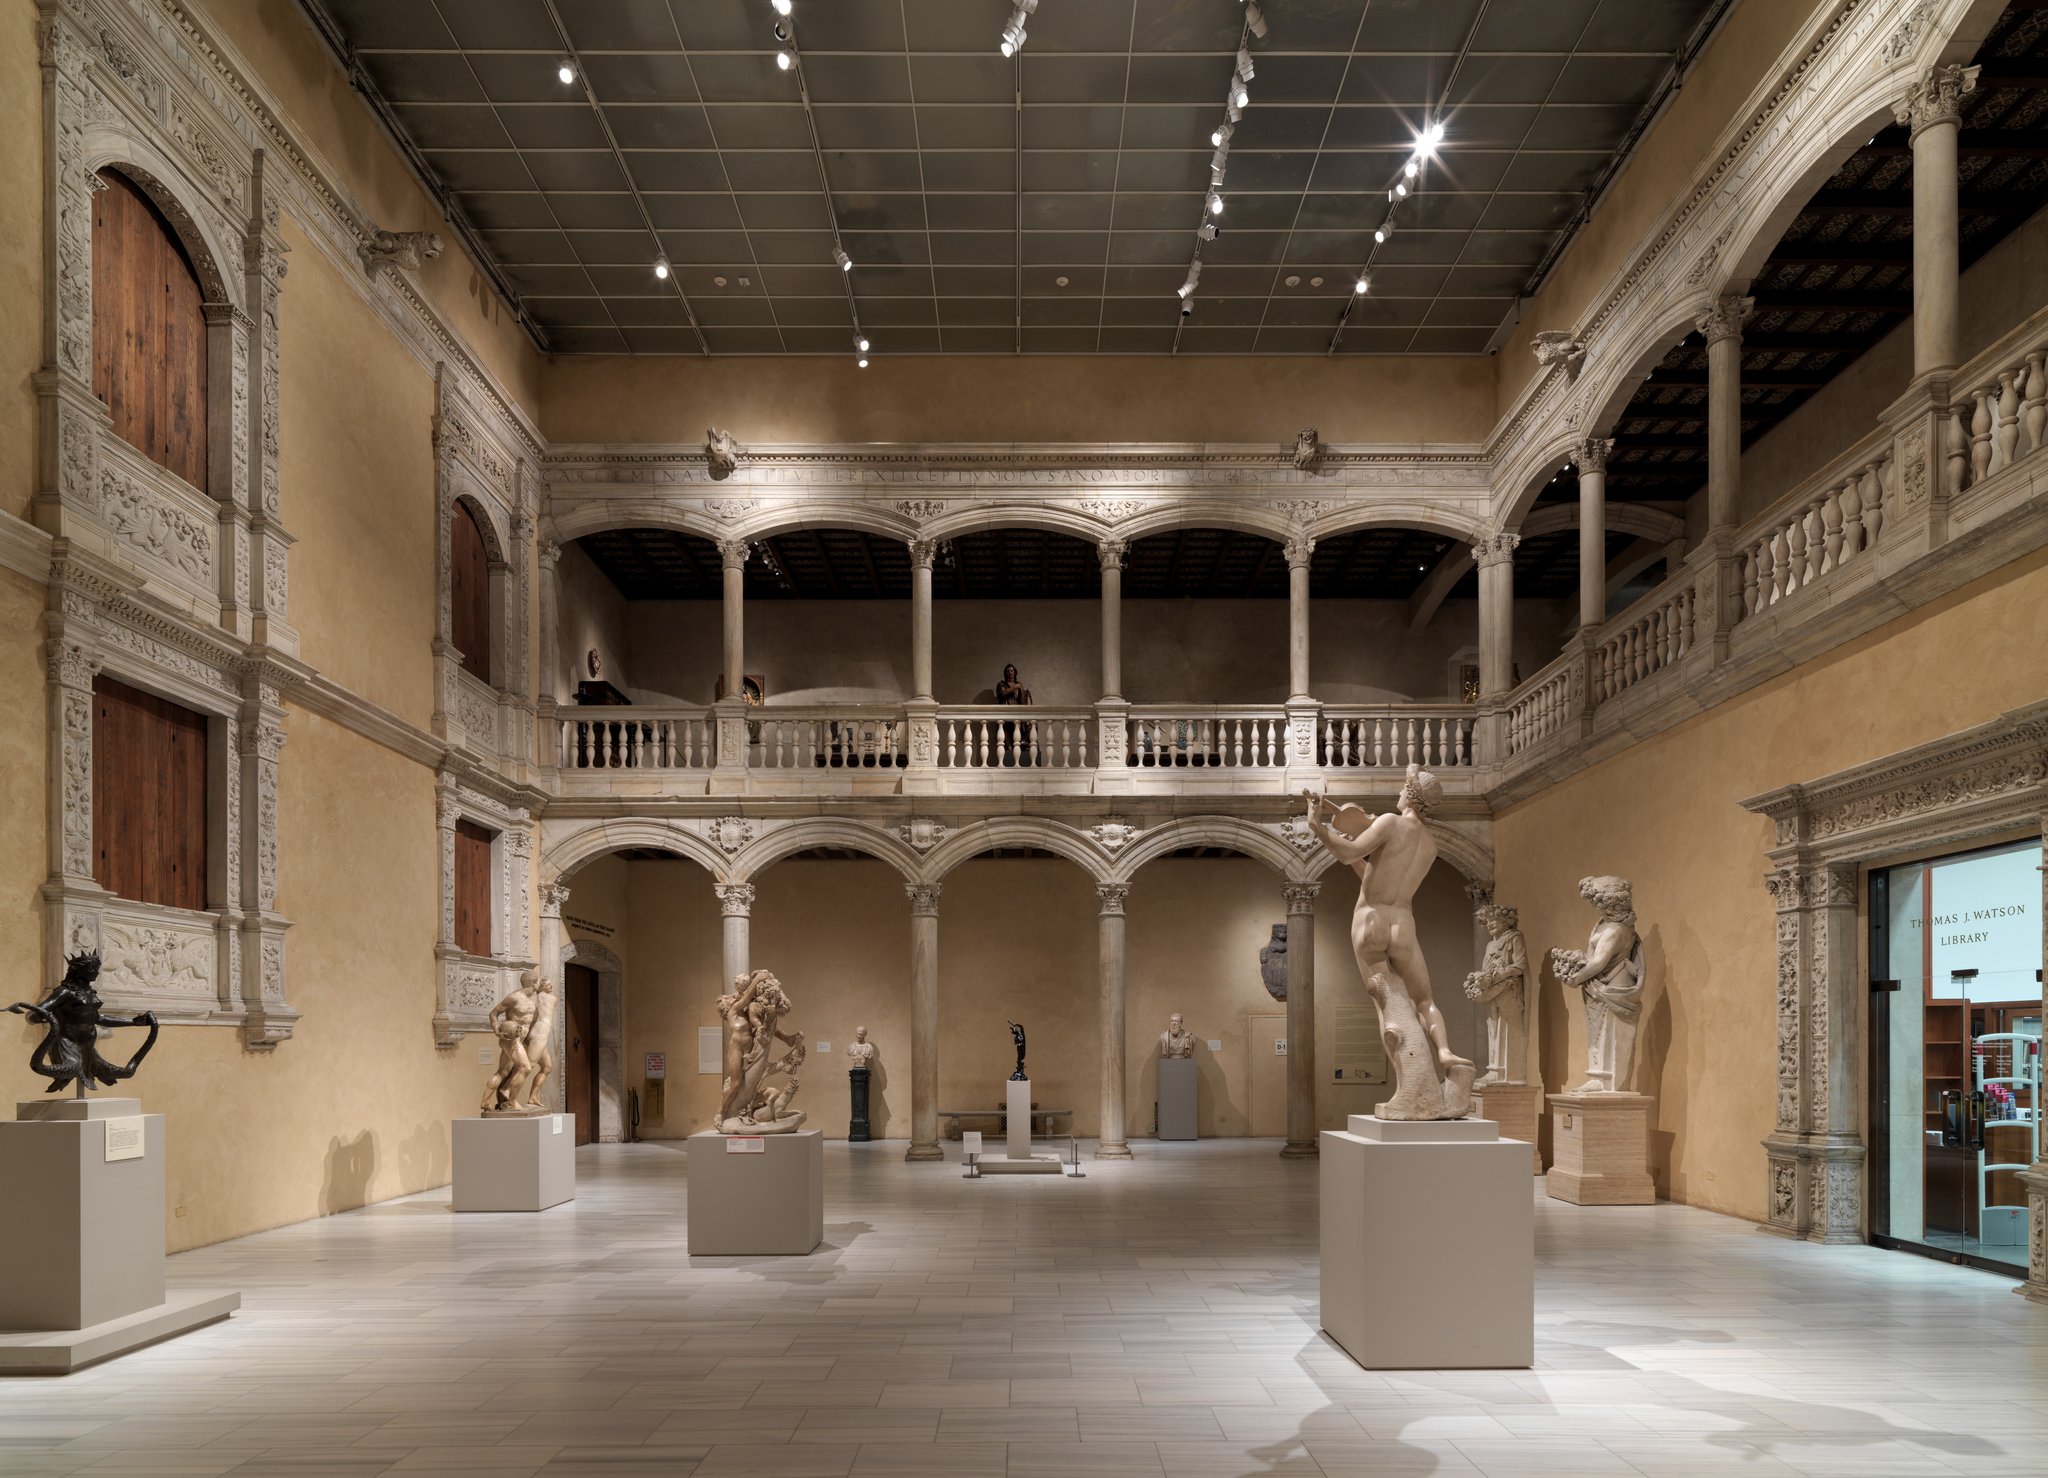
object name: period room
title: Patio from the Castle of Vélez Blanco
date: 1506-1515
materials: marble